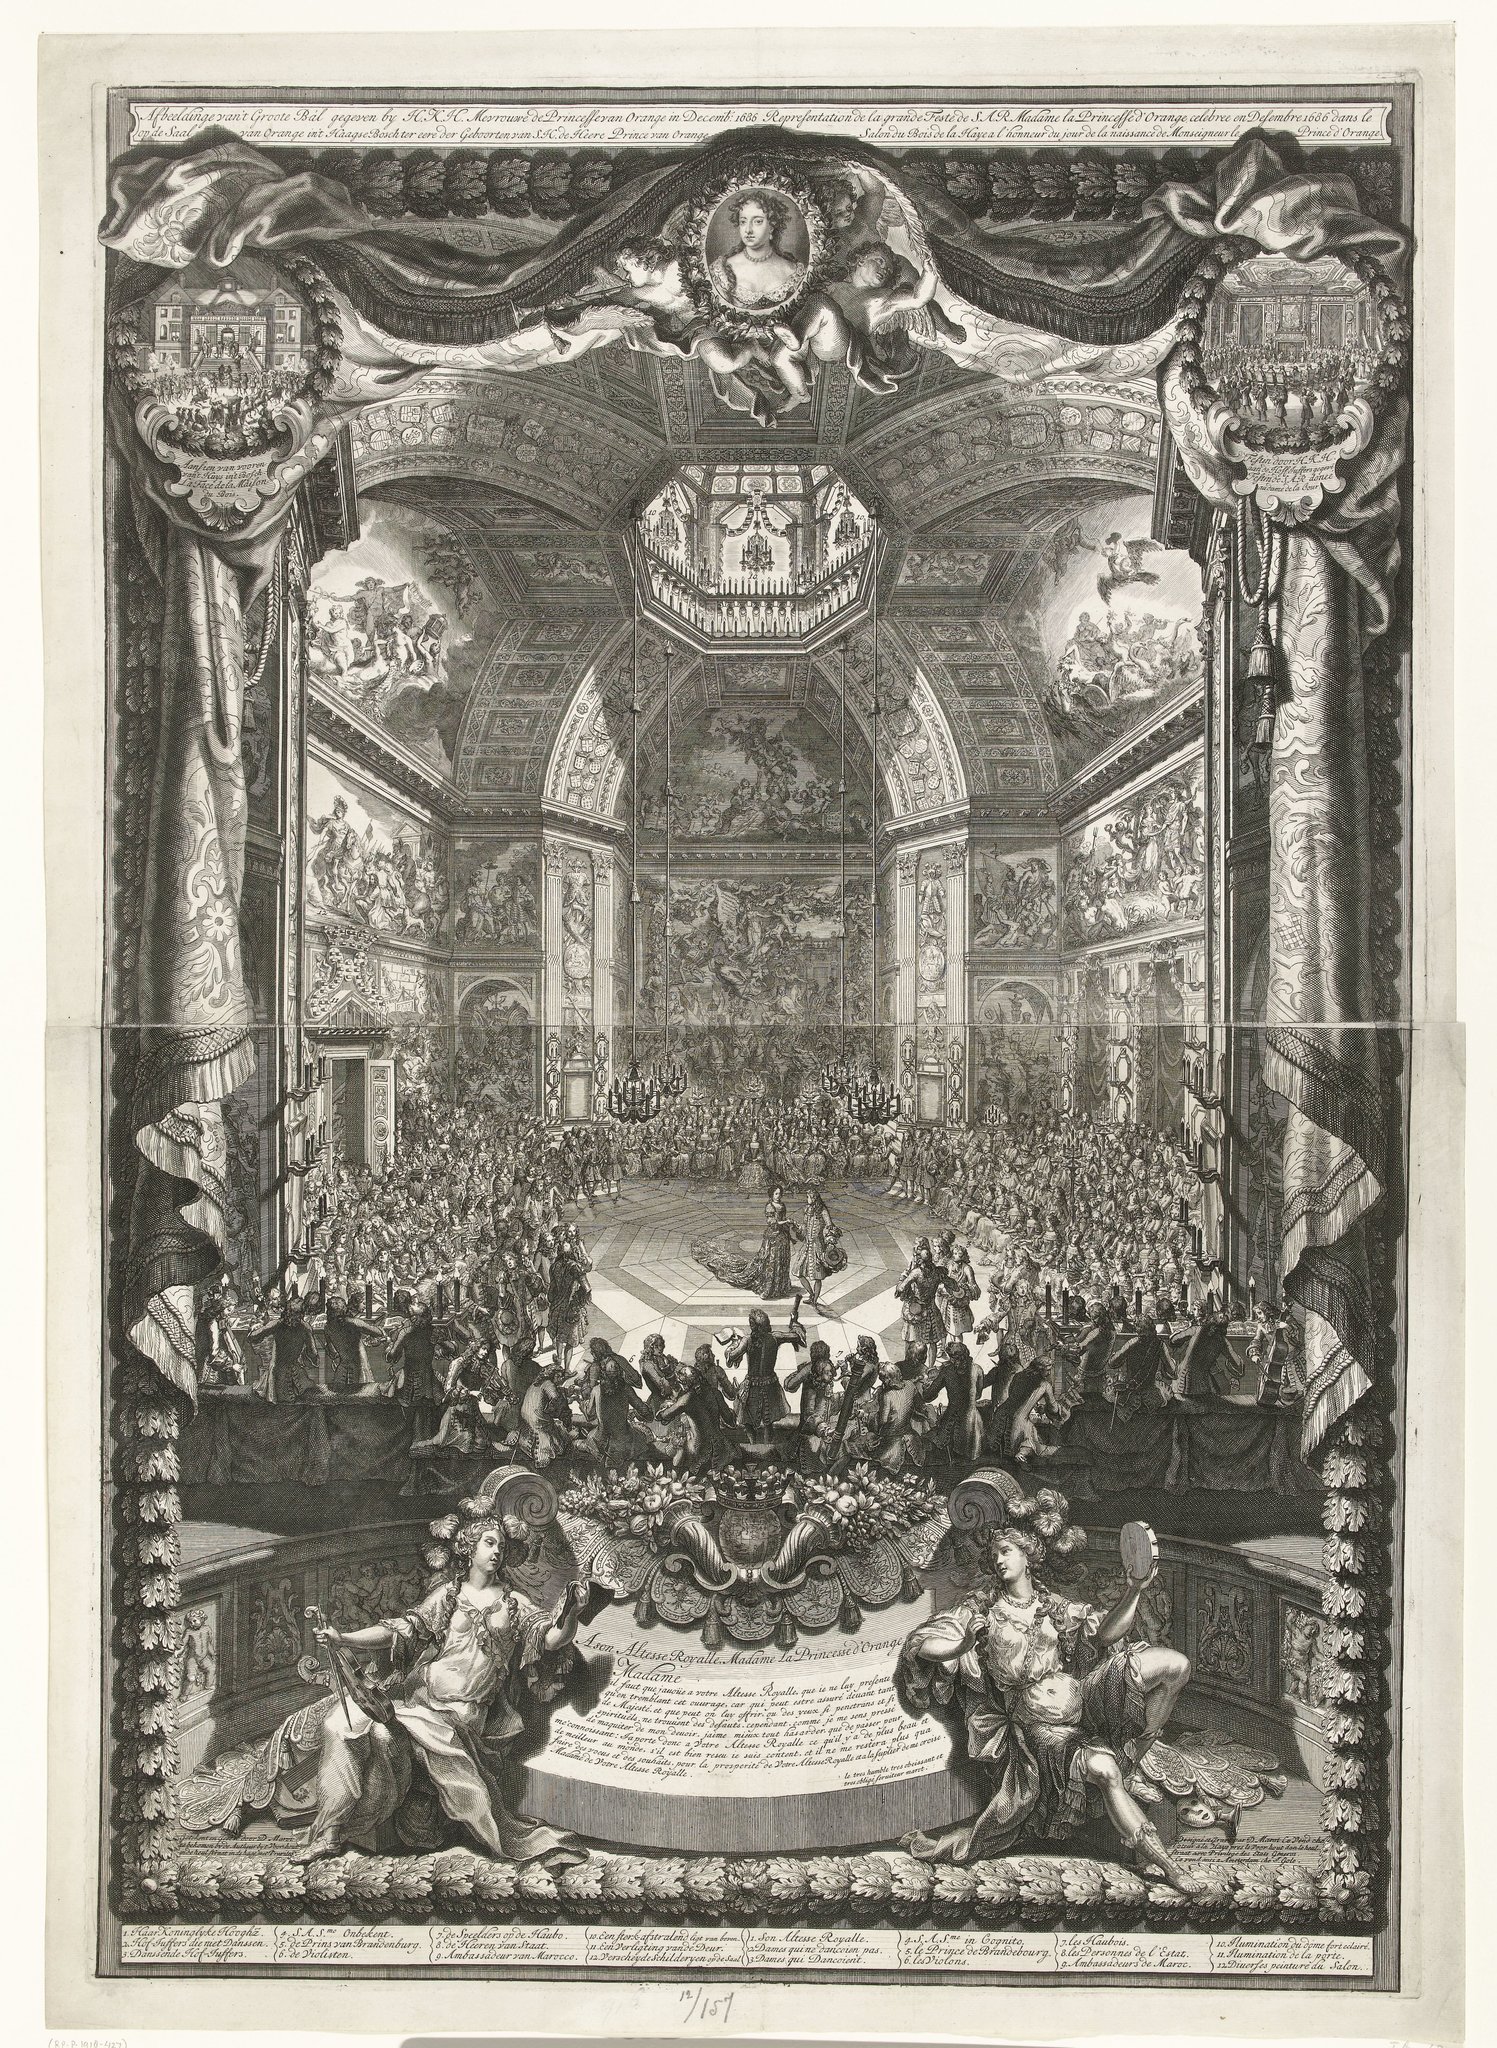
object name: print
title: Bal in het Huis ten Bosch ter ere van de verjaardag van de prins van Oranje, 1686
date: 1686-1687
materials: paper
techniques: engraving, etching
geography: the hague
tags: the hague, william iii (prince of orange and king of england, scotland, and ireland), london, maria ii stuart (koningin van engeland, schotland en ierland), ball, formal dance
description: Bal in de Oranjezaal van het paleis Huis ten Bosch gegeven door Maria prinses van Oranje ter ere van de verjaardag van Willem III, de prins van Oranje, december 1686. Centraal op de vloer de prins en prinses, hier omheen een grote groep zittende en staande edelen. Bovenaan een portret van de prinses met putti, onderaan een cartouche met de opdracht aan de prinses met twee vrouwenfiguren met viool en tamboerijn. Met titels en legenda's 1-12 in het Nederlands en Frans. Gedrukt van twee platen.